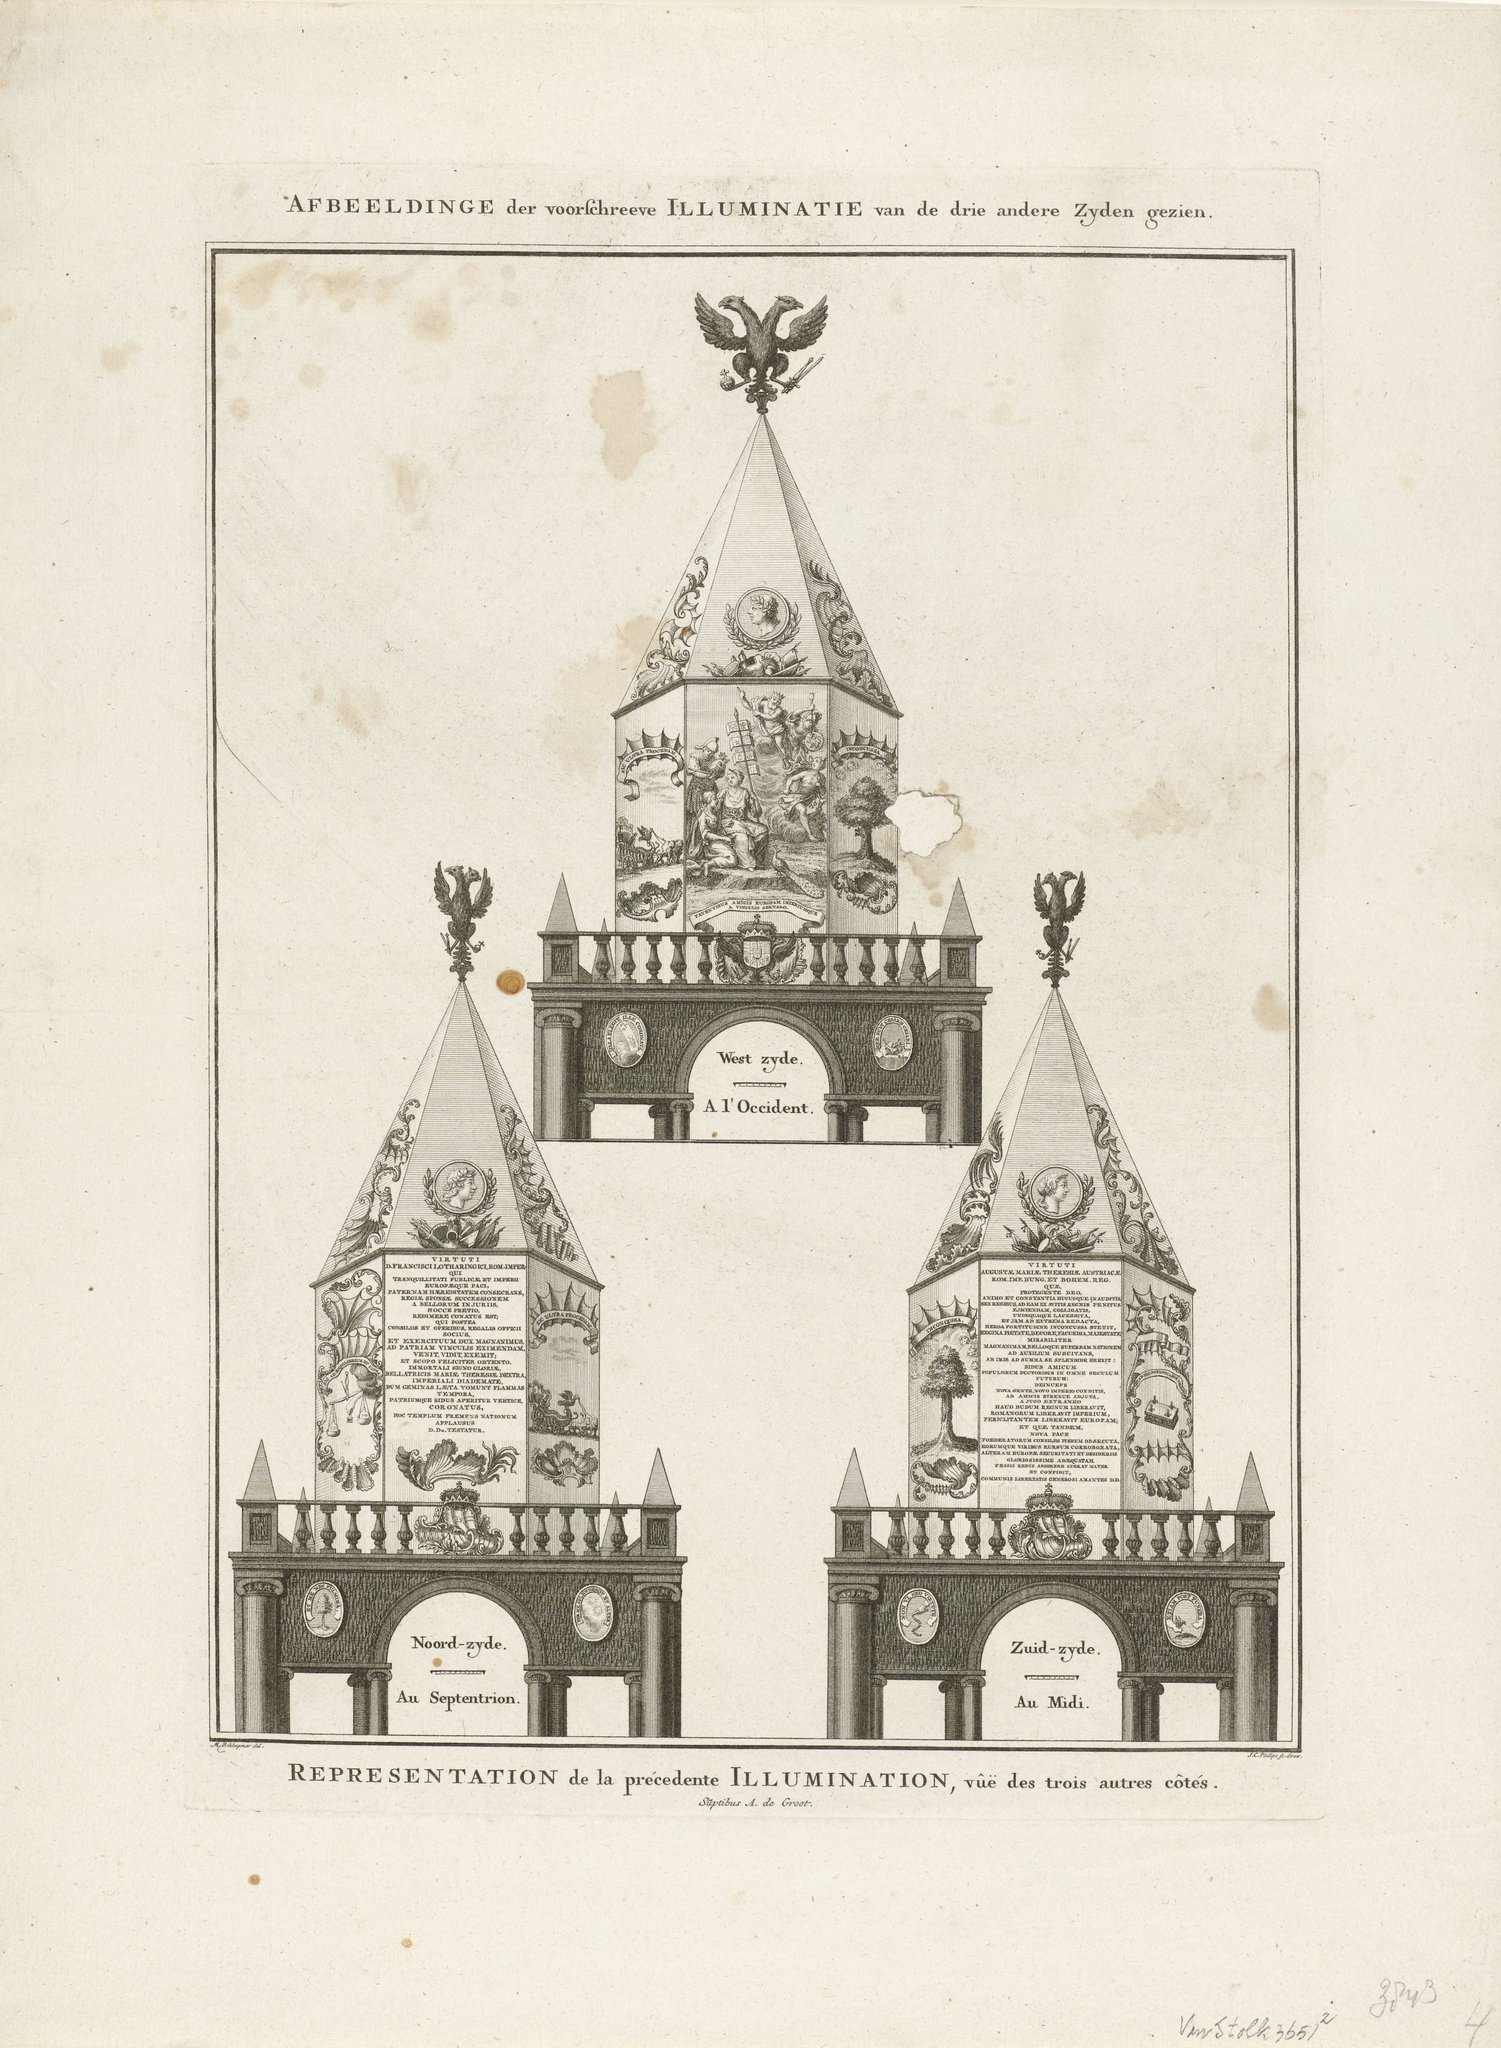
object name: print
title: Details van de decoraties op het bouwwerk voor het vuurwerk op de Hofvijver ter ere van de kroning van keizer Frans I Stefan, 1746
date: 1746-1747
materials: paper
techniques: engraving, etching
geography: northern netherlands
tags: frans i stefan (duits keizer), public festivities (+ illumination, fire-works ~ festive activities), coronation of a ruler, bonfire, fire-works (+ illumination, fire-works ~ festive activities)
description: De details van de decoraties op het bouwwerk (tempel of gevaarte), van drie kanten gezien, voor het vuurwerk afgestoken op 19 januari 1746 op de Hofvijver te Den Haag in opdracht van de Duitse minister en afgezant baron van Reischach, ter gelegenheid van de kroning van Frans I Stefan tot keizer op 4-6 oktober 1745.